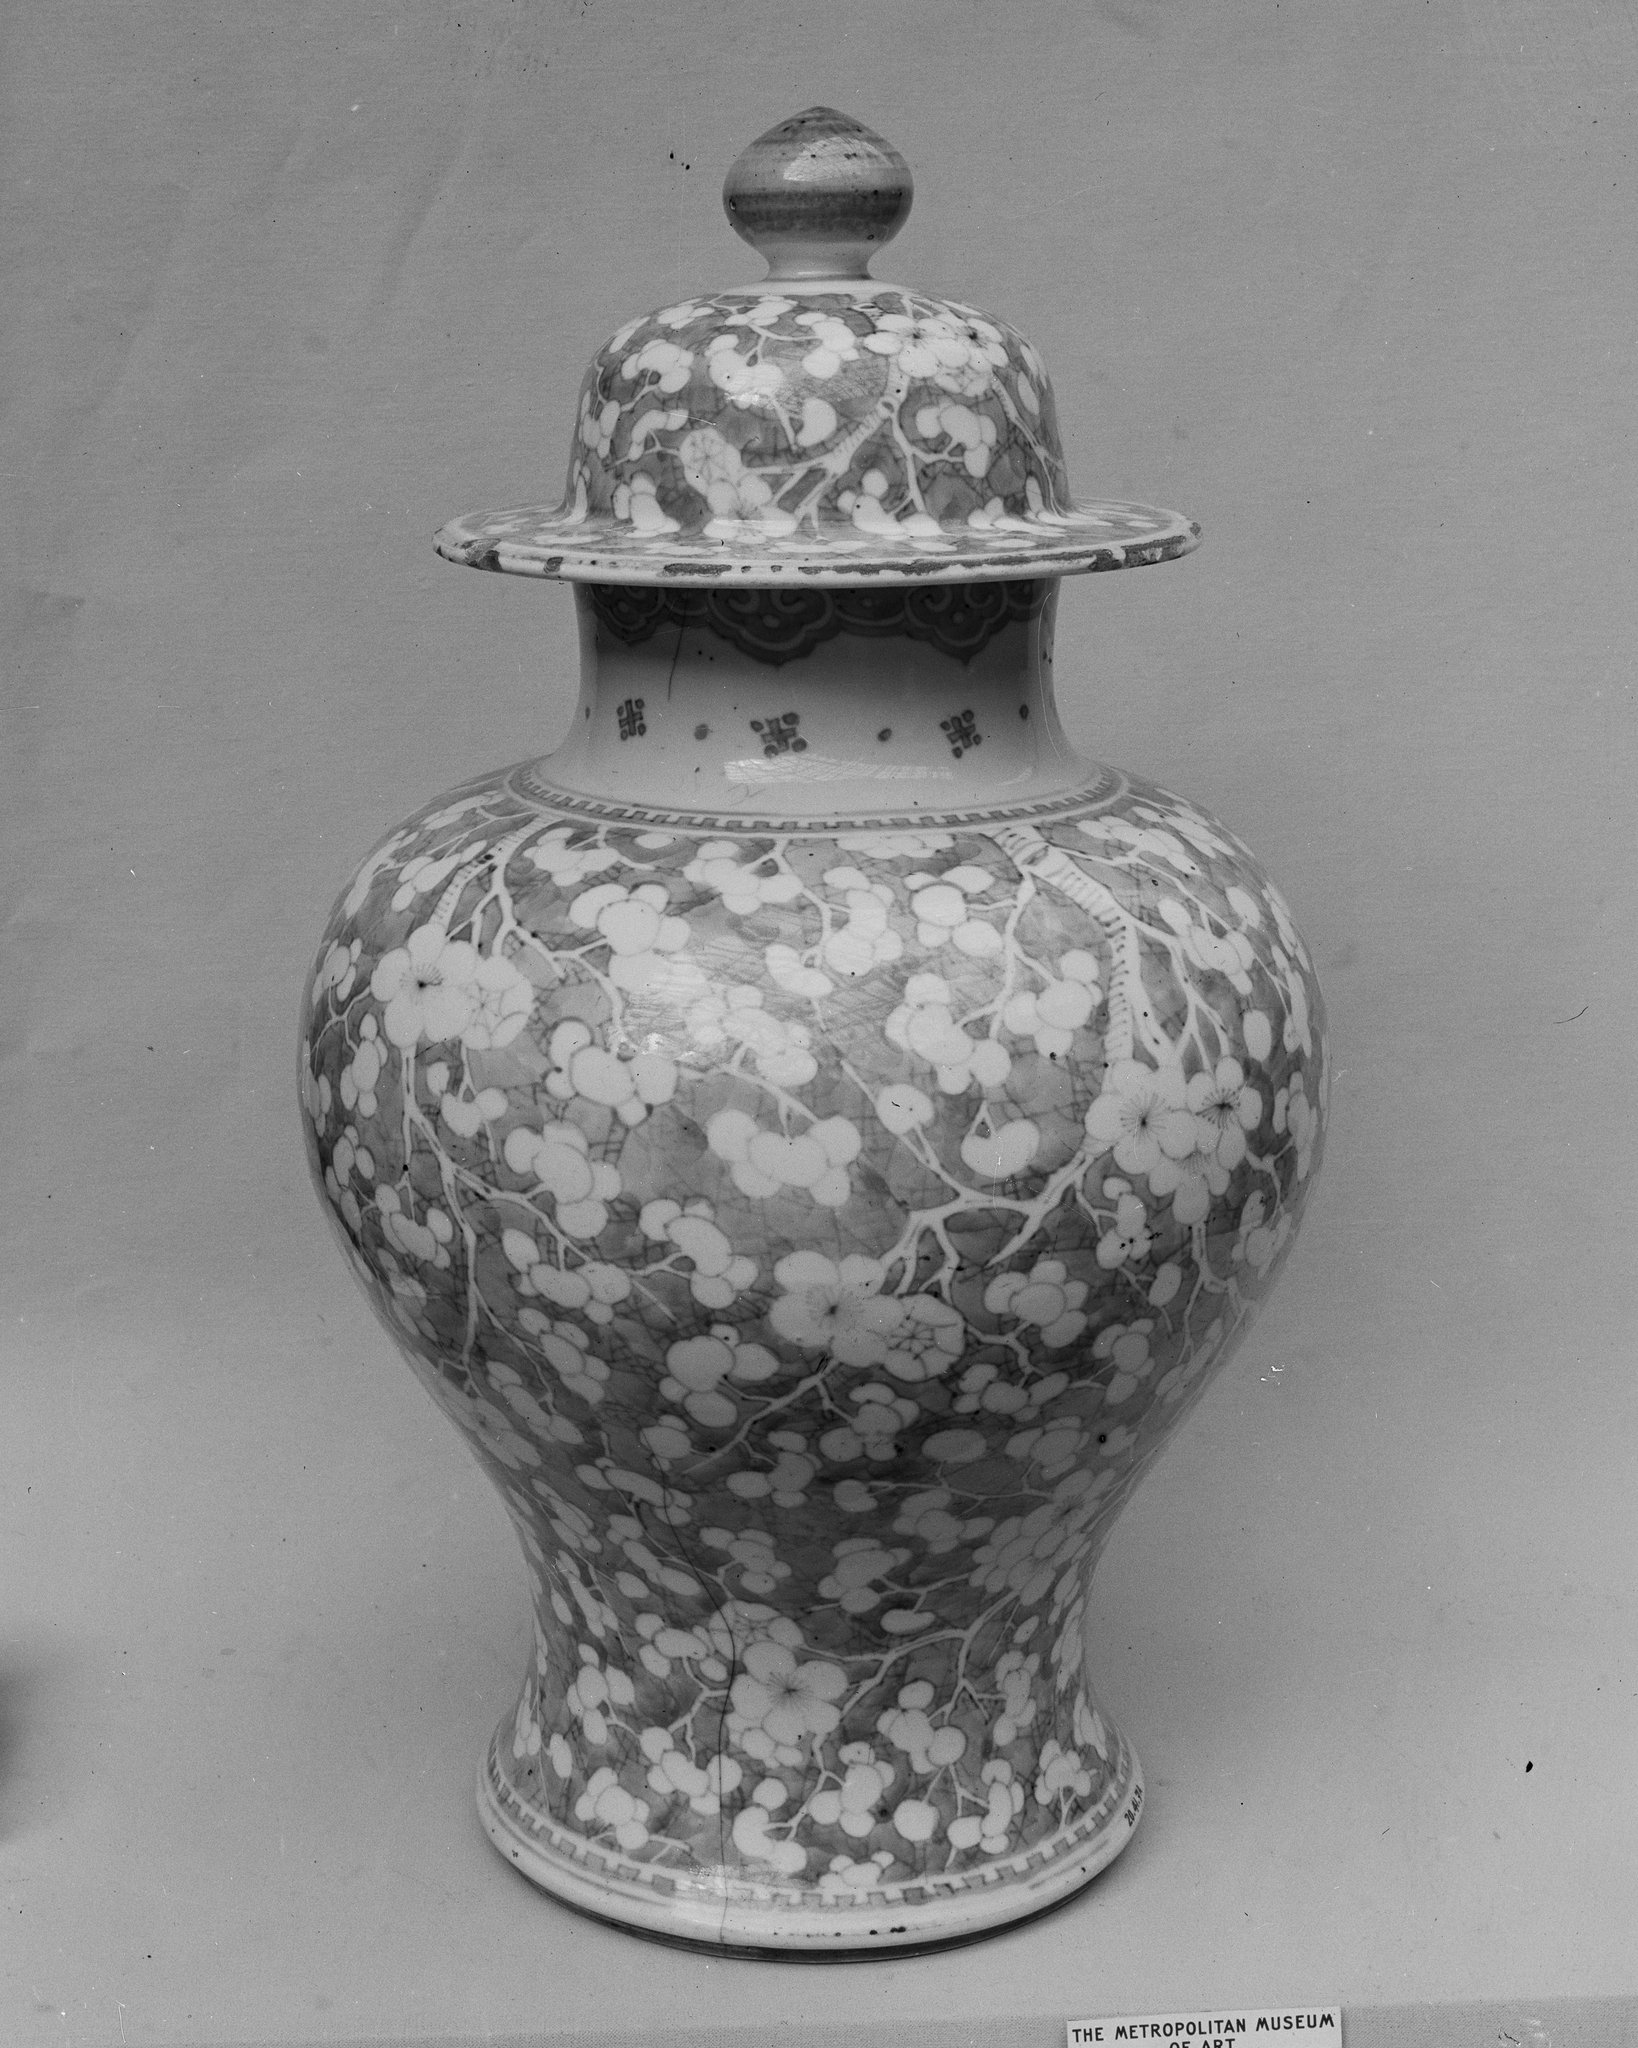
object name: covered jar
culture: chinese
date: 1662-1722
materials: porcelain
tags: flowers